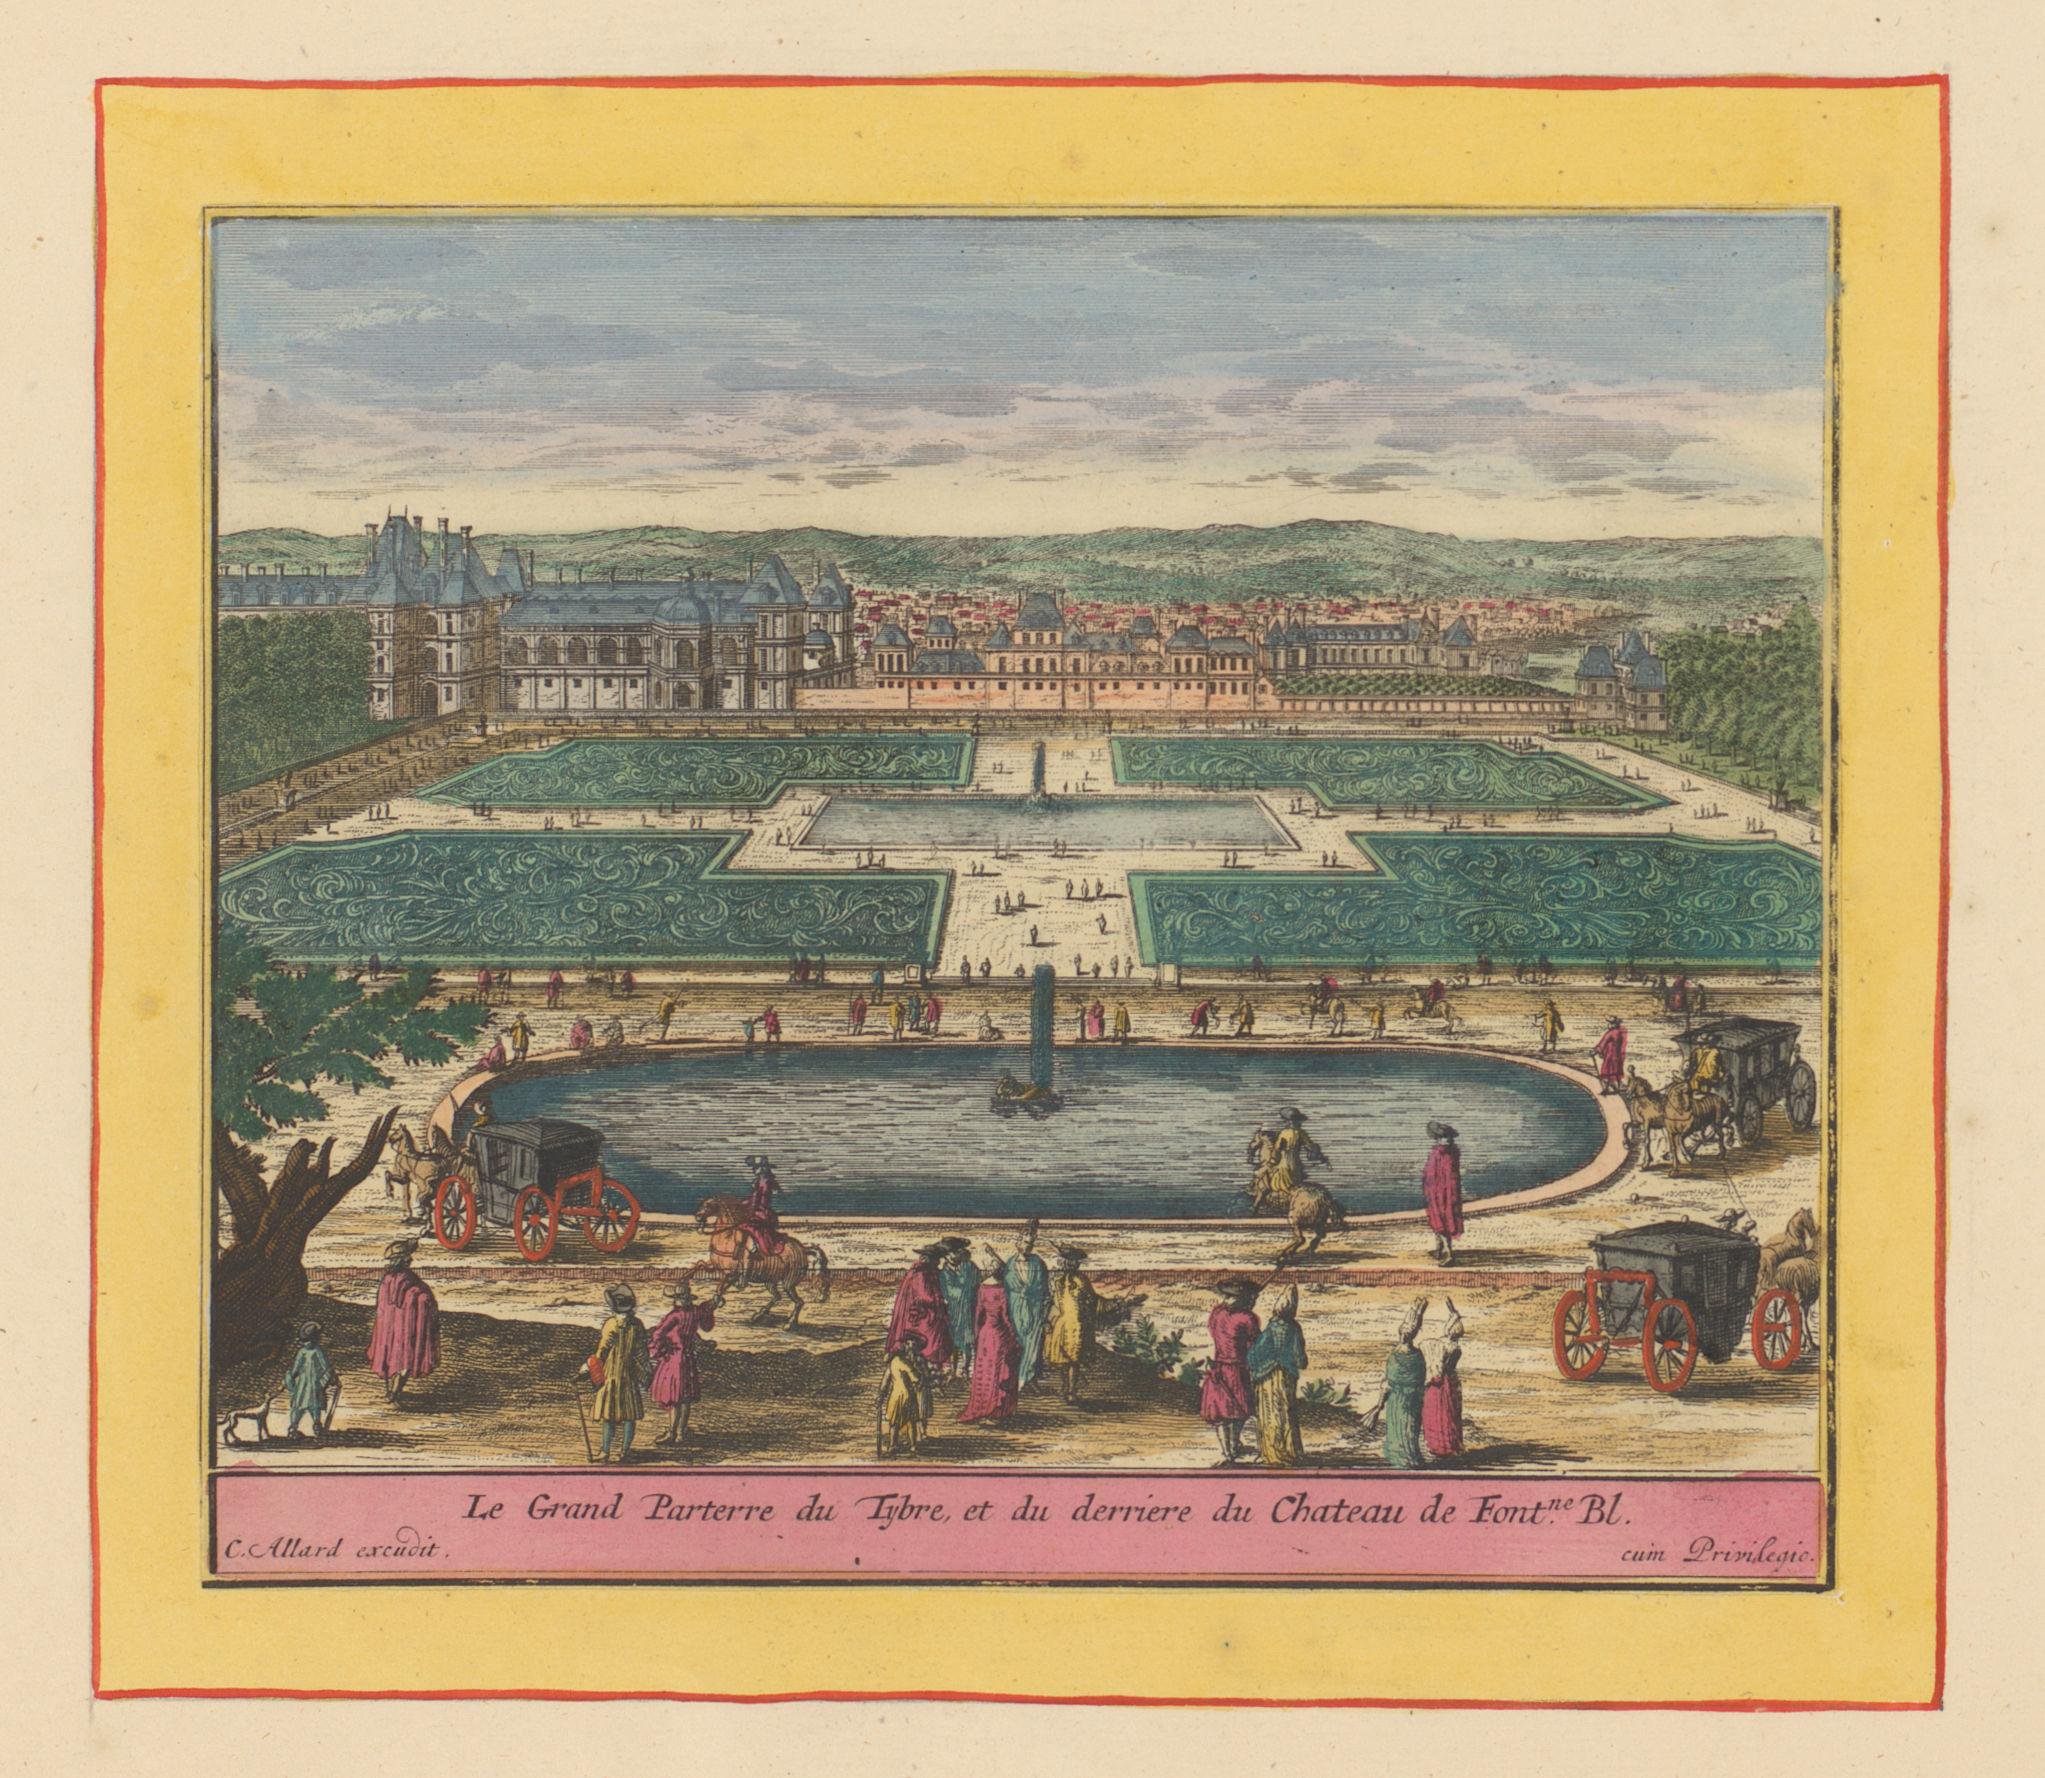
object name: album leaf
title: Gezicht op de Parterre en de Bassin de Tibre van het paleis van Fontainebleau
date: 1684-1709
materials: paper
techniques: etching, hand coloring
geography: northern netherlands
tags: palace, french or architectonic garden; formal garden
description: De Parterre en de Bassin de Tibre in de tuin van het paleis van Fontainebleau. Op de voorgrond staan figuren, rond de vijver rijden koetsen. Prent maakt deel uit van een album.